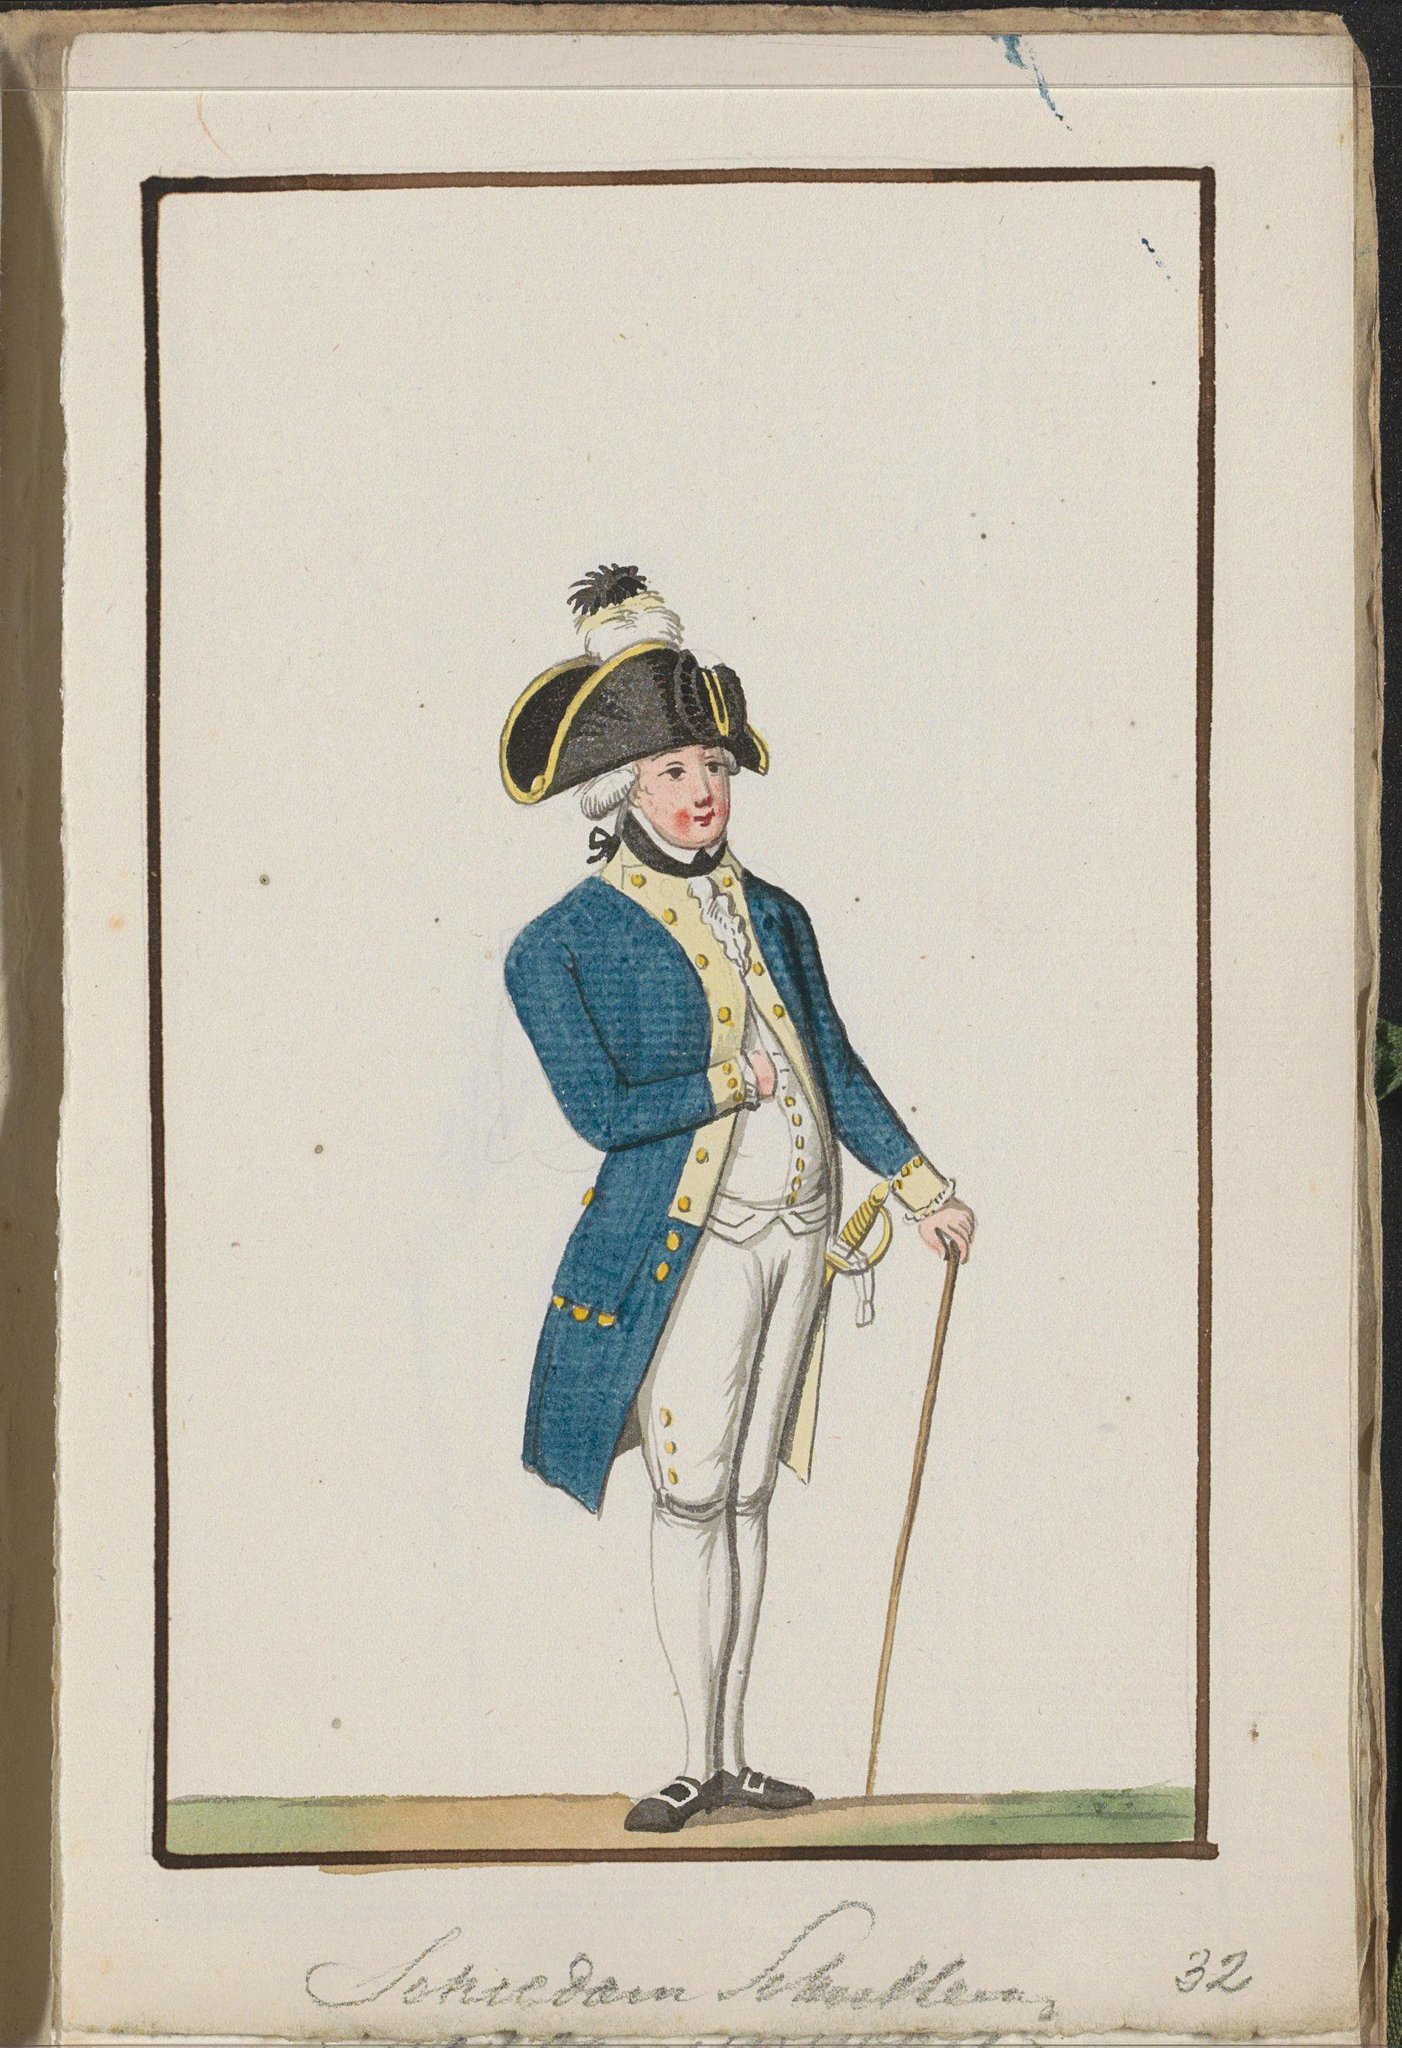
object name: drawing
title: Schiedam Schuttery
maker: Anonymous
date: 1789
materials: paper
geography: northern netherlands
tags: (military) uniforms (+ citizen soldiery, civil guard, citizen militia), patriots (1780-1795)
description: Montering of uniform van de schutterij van Schiedam, ca. 1785. Onderdeel van een schetsboek met 41 gekleurde tekeningen van de monteringen van de gewapende schutterijen en burgercorpsen in Nederland in de periode ca. 1783-1789.